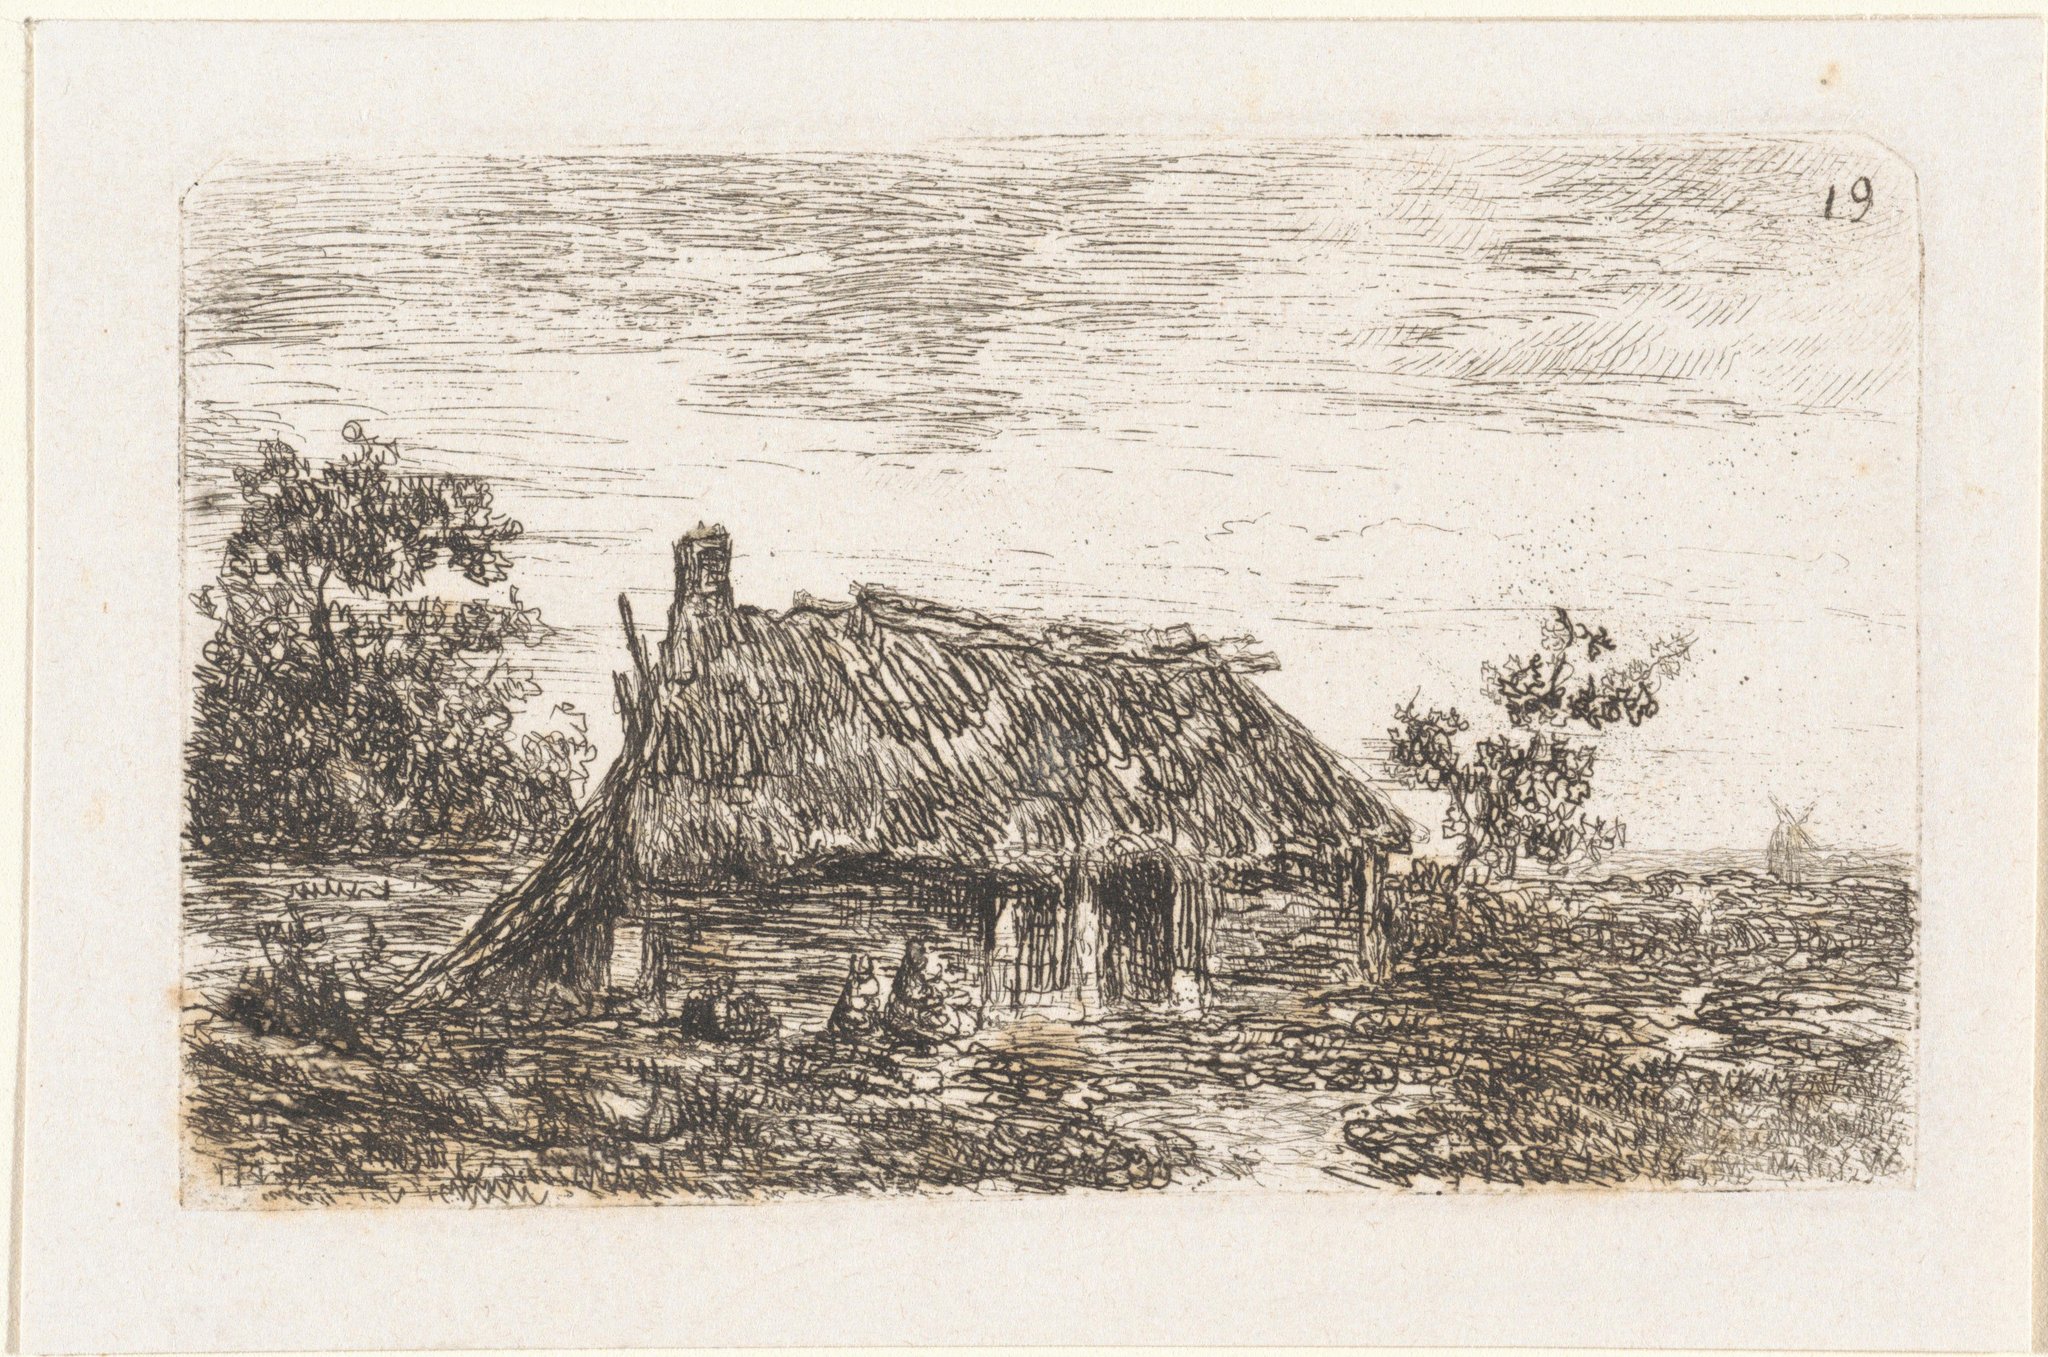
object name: print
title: Twee figuren voor een gebouw met een rieten dak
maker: johannes pieter van wisselingh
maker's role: draughtsman, painter, print maker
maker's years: 1812-1899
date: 1830-1899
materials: paper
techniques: etching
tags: rural housing, e.g. country-house, villa, cottage, windmill in landscape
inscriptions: collector's mark: Lugt 2228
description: Links zitten twee figuren voor een boerderij of hut met een rieten dak. Linksachter enkele bomen en rechtsachter een molen. Rechtsboven het getal 19.